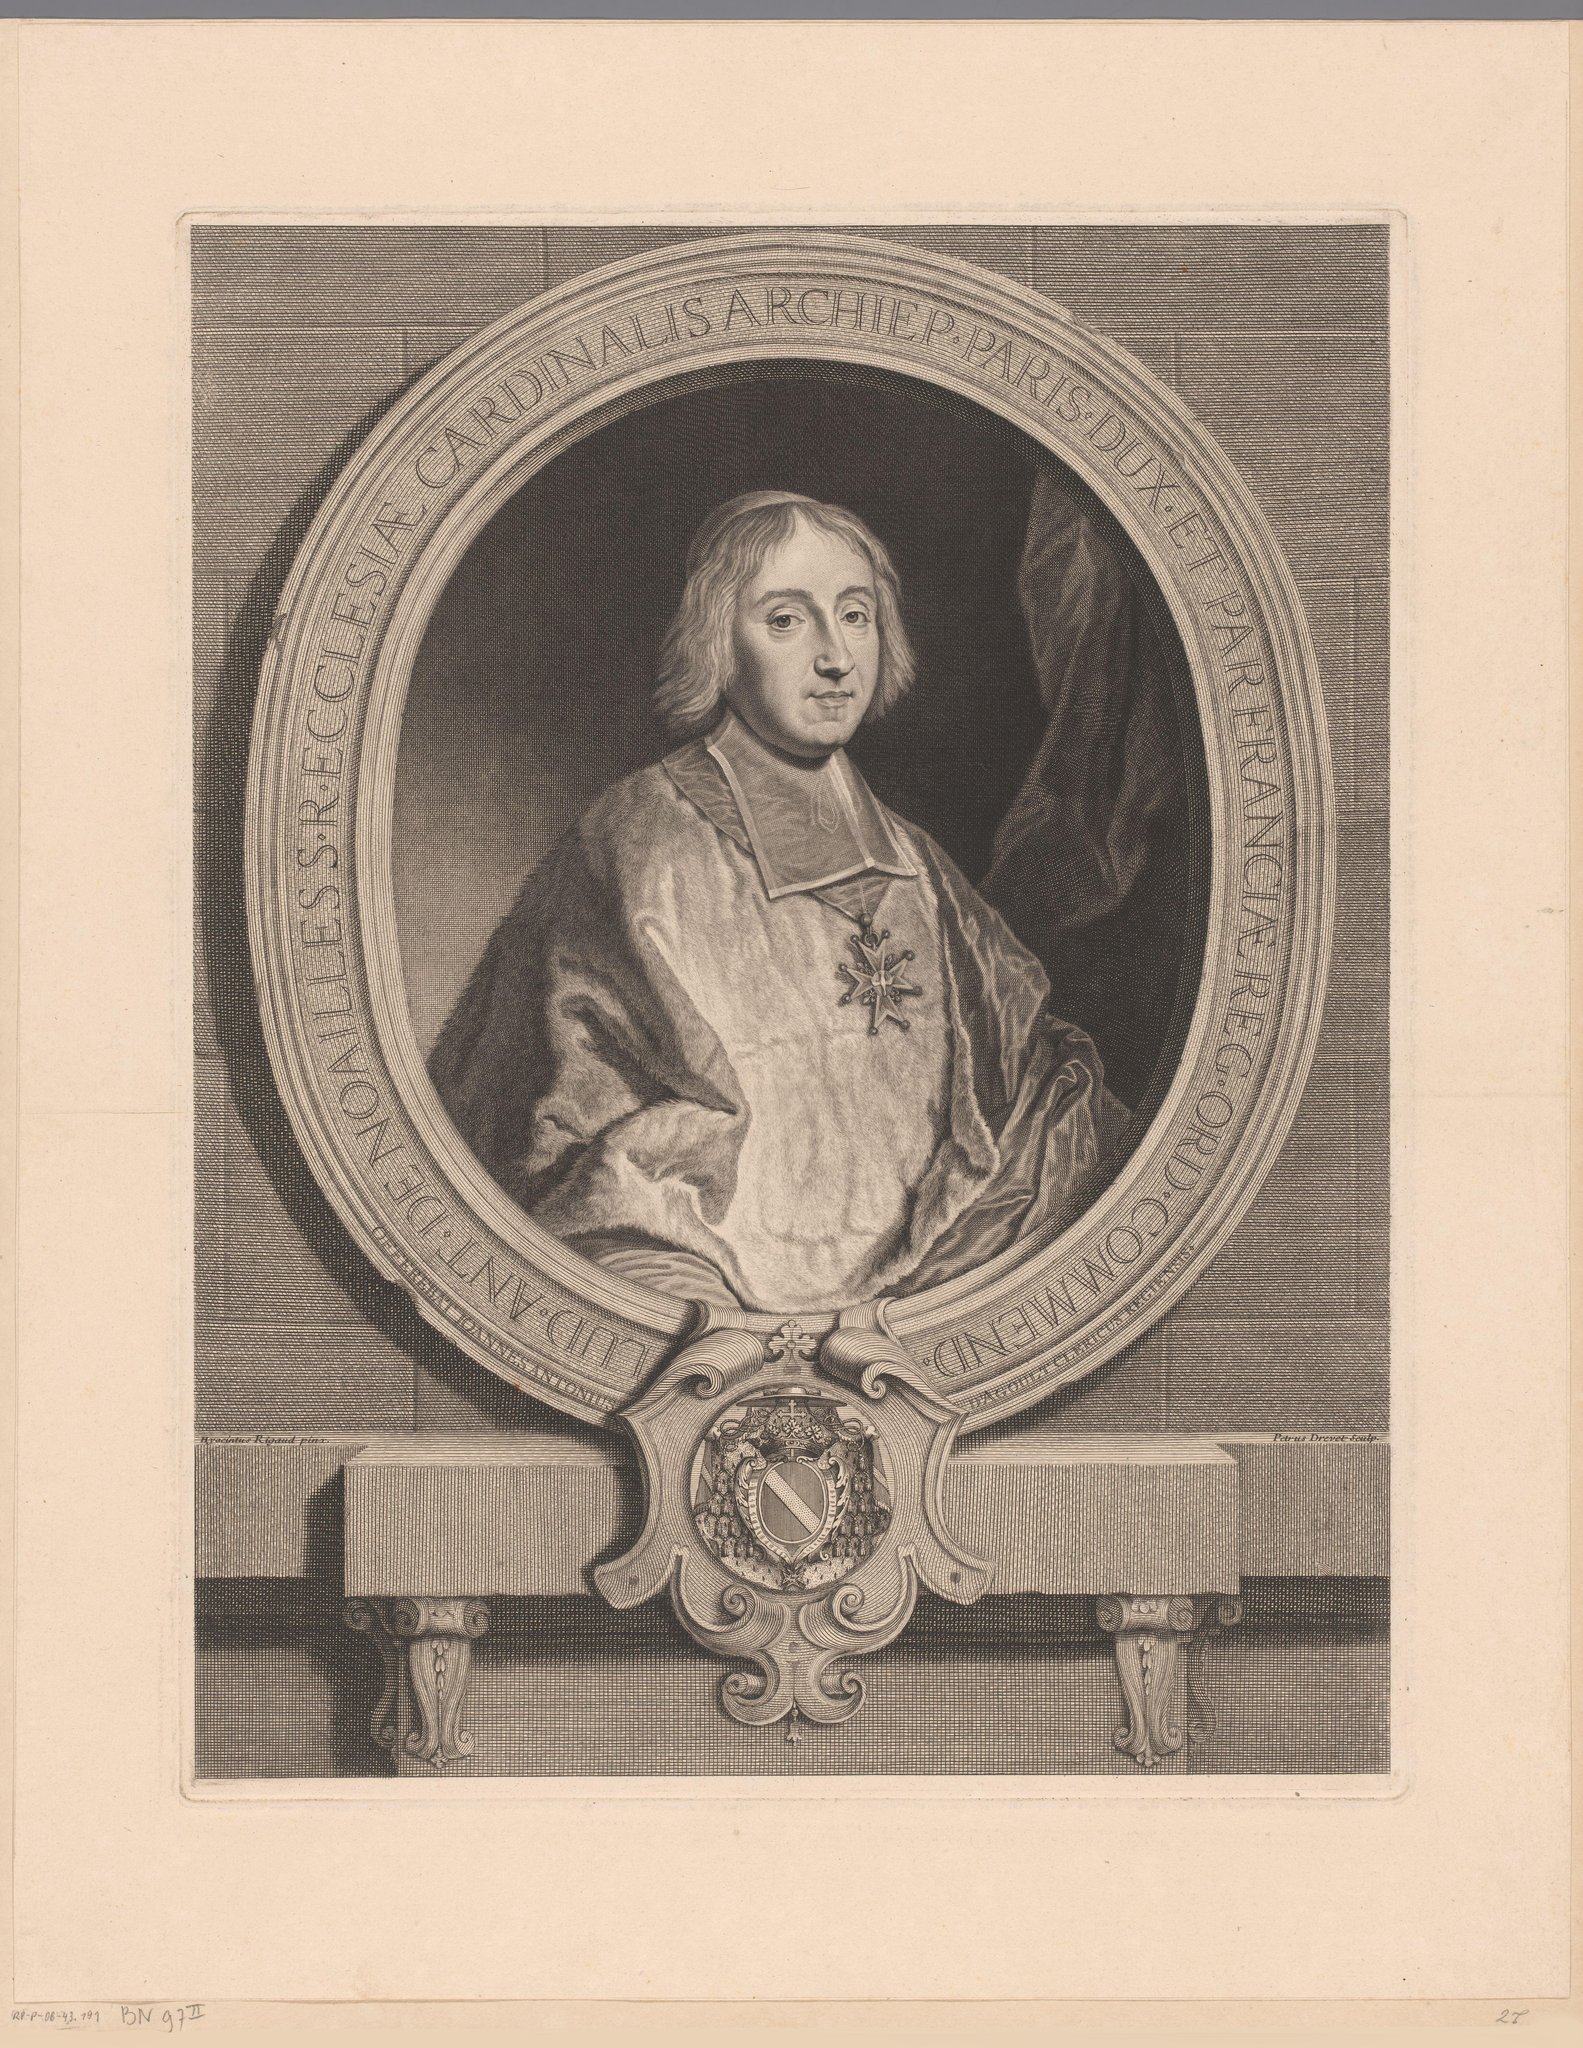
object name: print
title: Portret van Louis Antoine de Noailles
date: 1700-1729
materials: paper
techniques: engraving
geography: france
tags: paris, priest, louis-antoine de noailles, cardinal, historical persons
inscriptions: collector's mark: Lugt 240